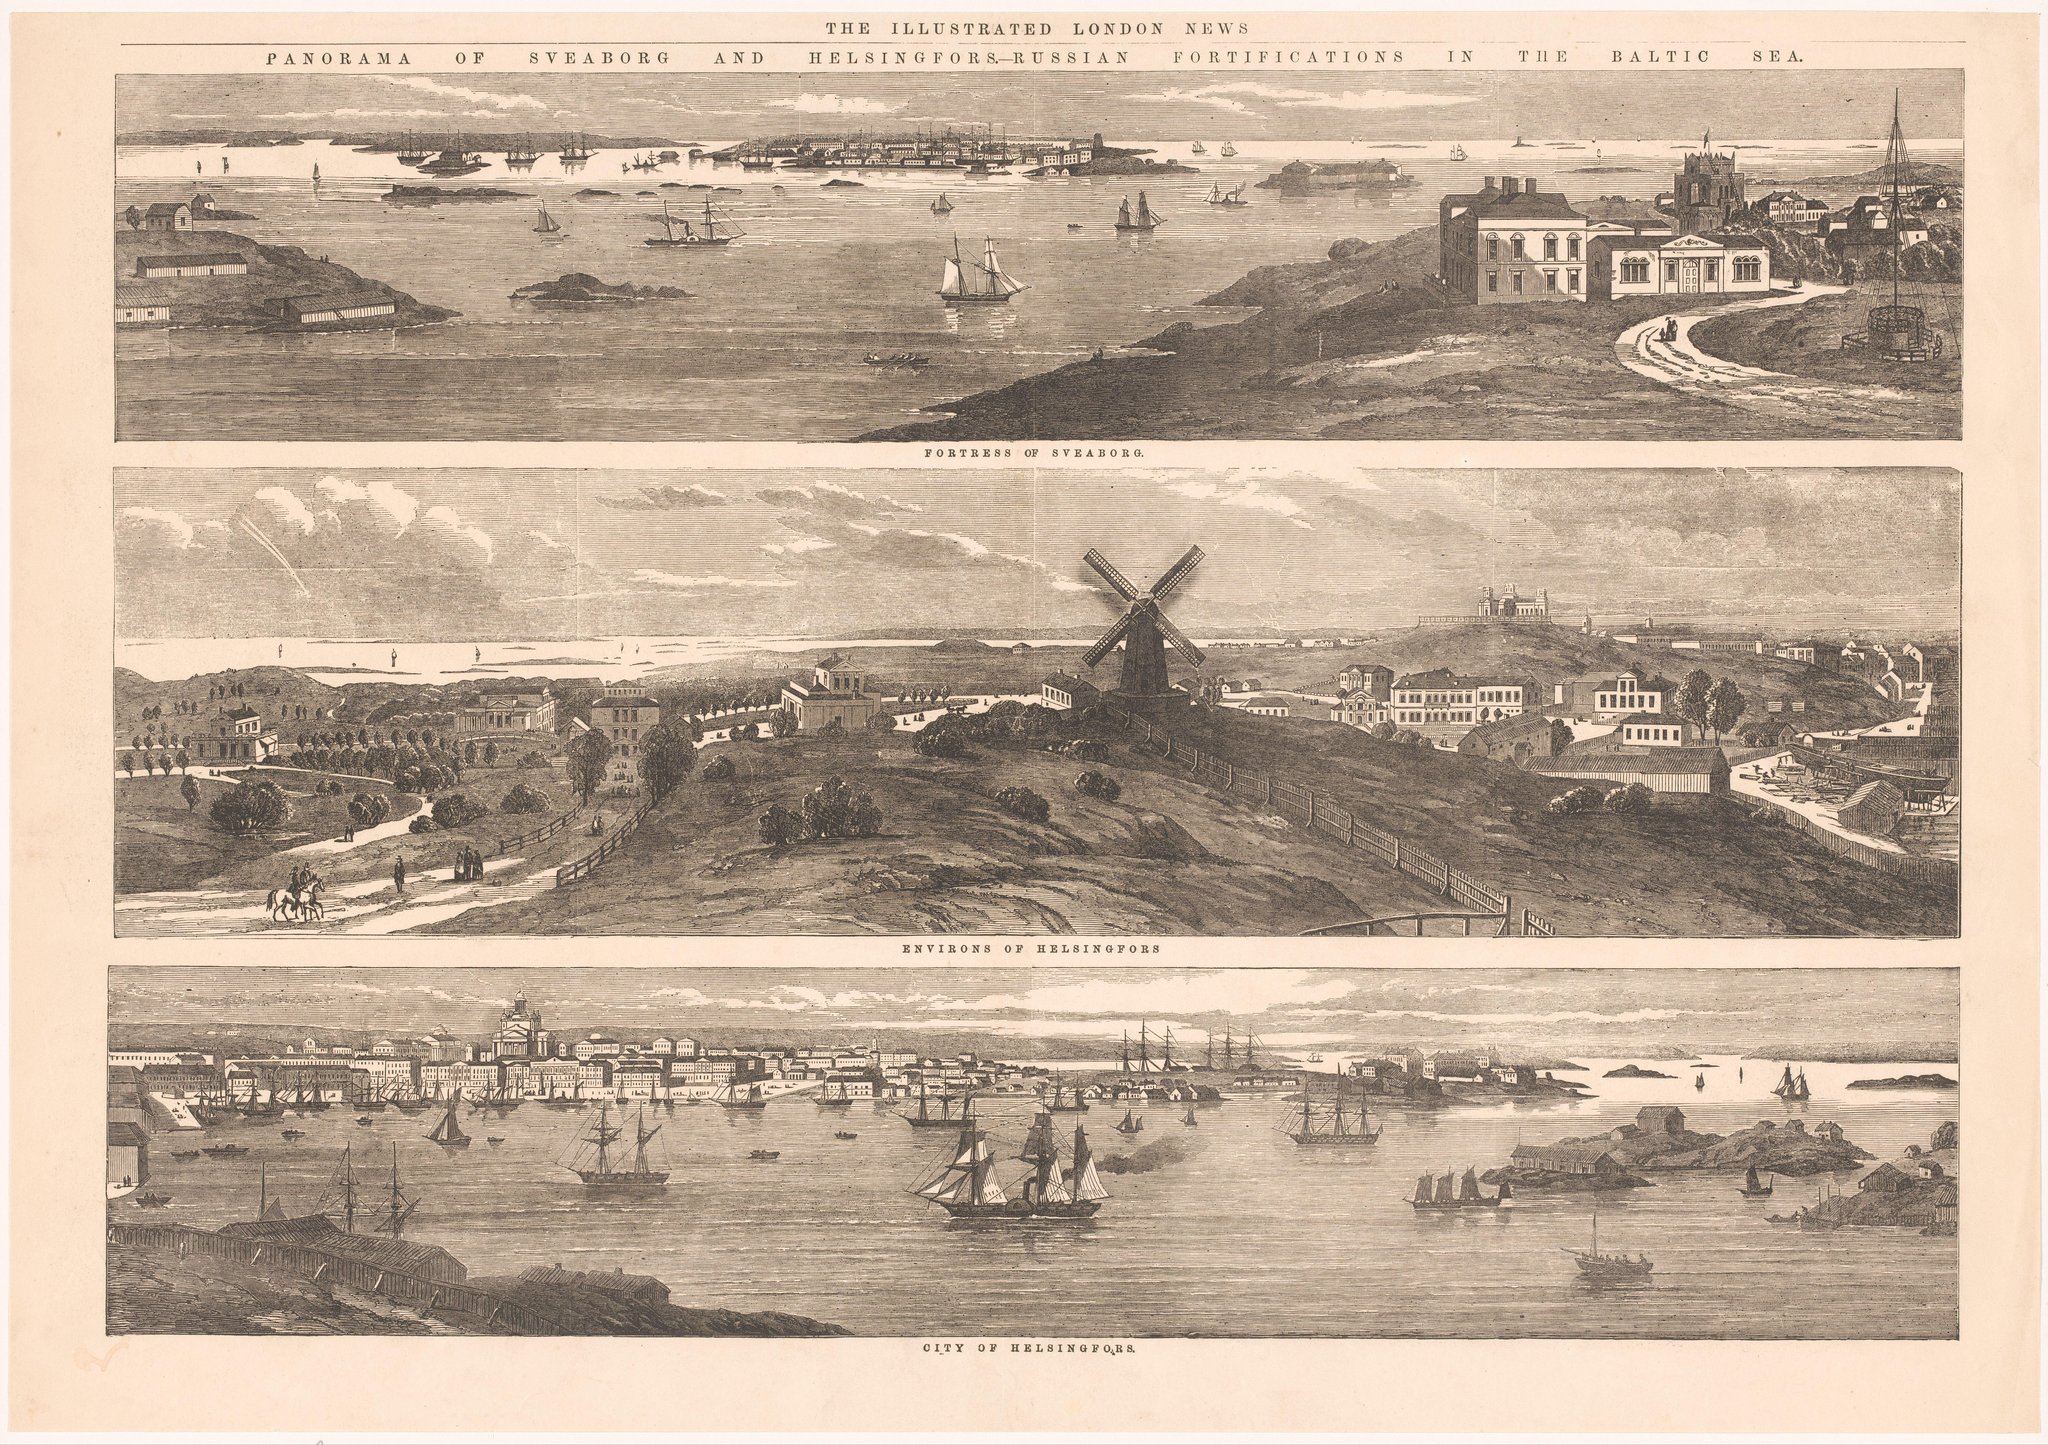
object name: print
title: Gezicht op Suomenlinna, de omgeving van Helsinki en Helsinki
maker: Anonymous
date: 1855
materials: paper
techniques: engraving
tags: fortress, prospect of city, town panorama, silhouette of city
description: Prent gebruikt in: The Illustrated London News, 14 april 1855.